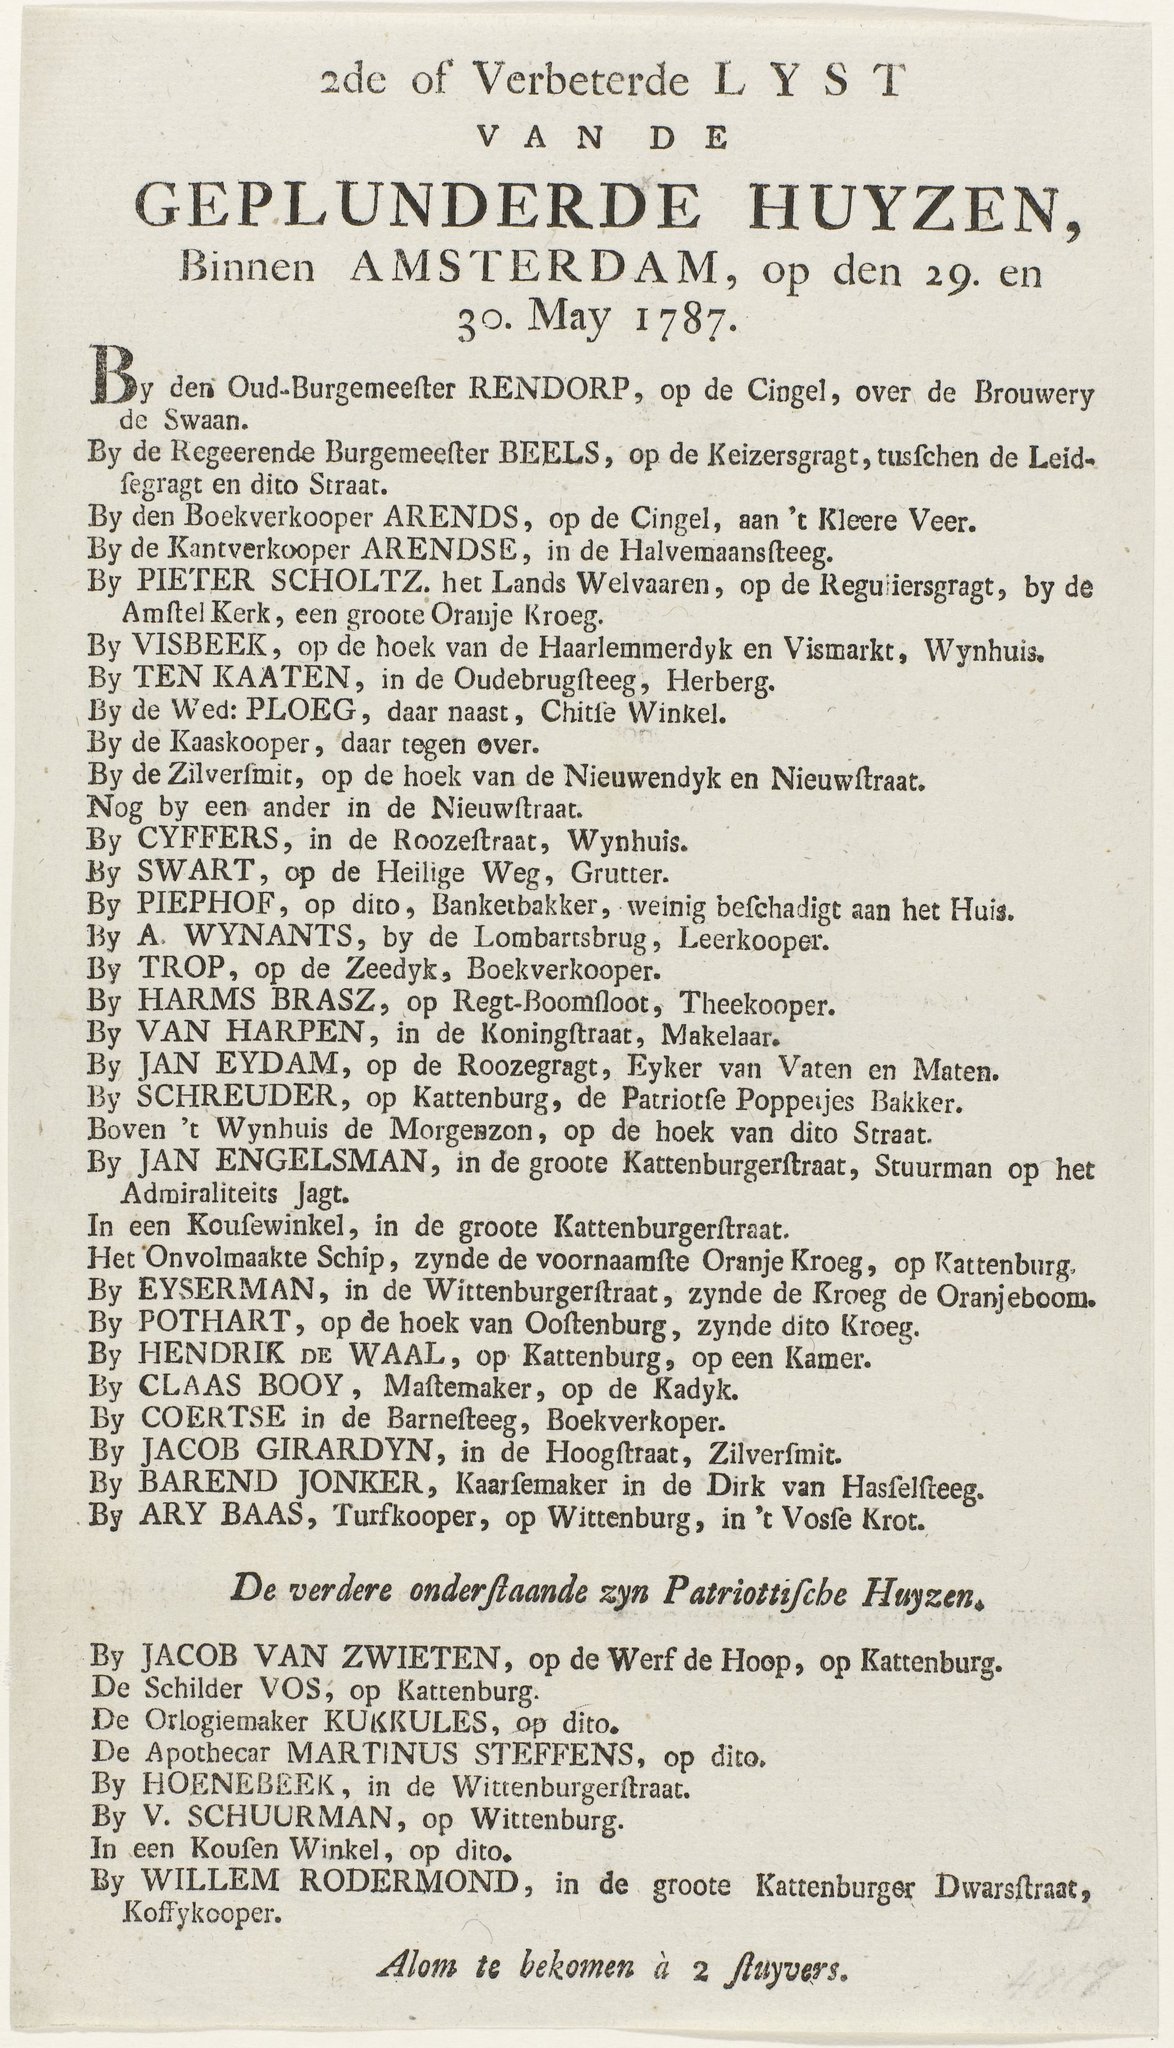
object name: text sheet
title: 2de of Verbeterde Lyst van de Geplunderde Huyzen, Binnen Amsterdam, op den 29. en 30. May 1787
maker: Anonymous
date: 1787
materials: paper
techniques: letterpress printing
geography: northern netherlands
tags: amsterdam, patriots (1780-1795)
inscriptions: collector's mark: Lugt 2228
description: Gedrukte herziene lijst van de huizen van Orangisten, en enkele Patriotten, in Amsterdam geplunderd op 29 en 30 mei 1787.